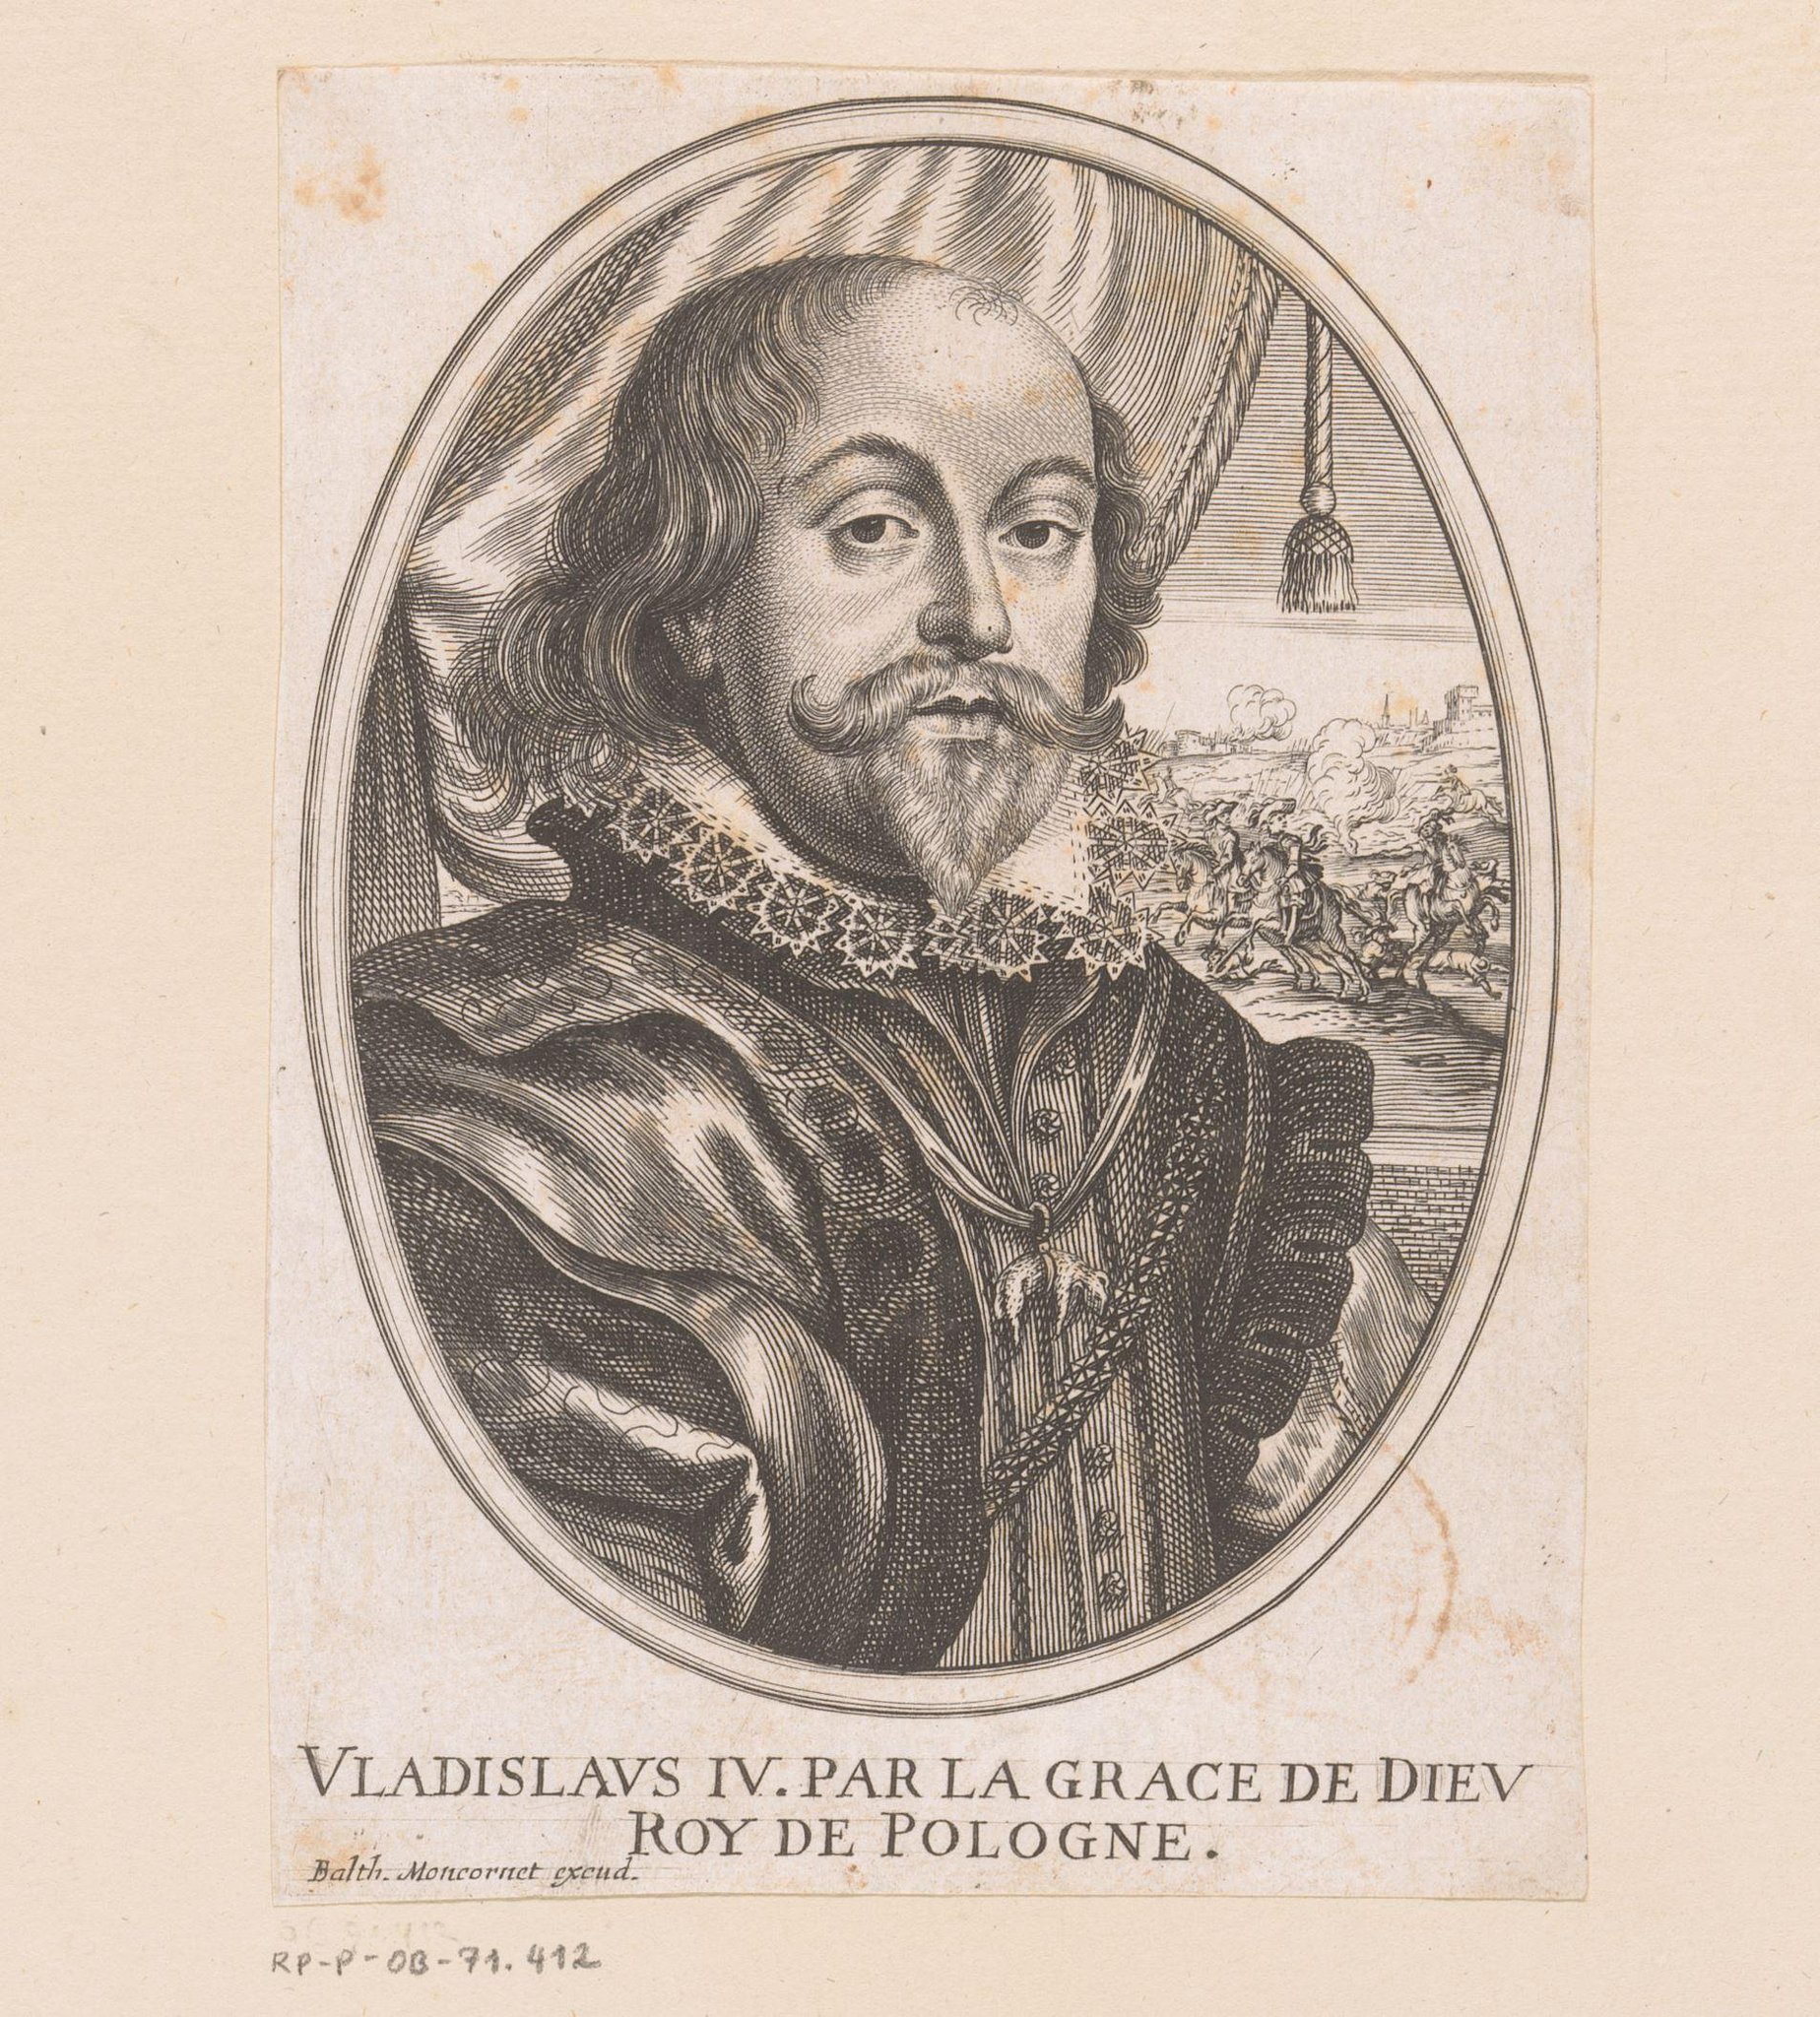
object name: print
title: Portret van Wladislaus Wasa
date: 1625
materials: paper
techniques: engraving, etching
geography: paris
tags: wladislaus wasa (iv), historical persons, king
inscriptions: collector's mark: Lugt 240